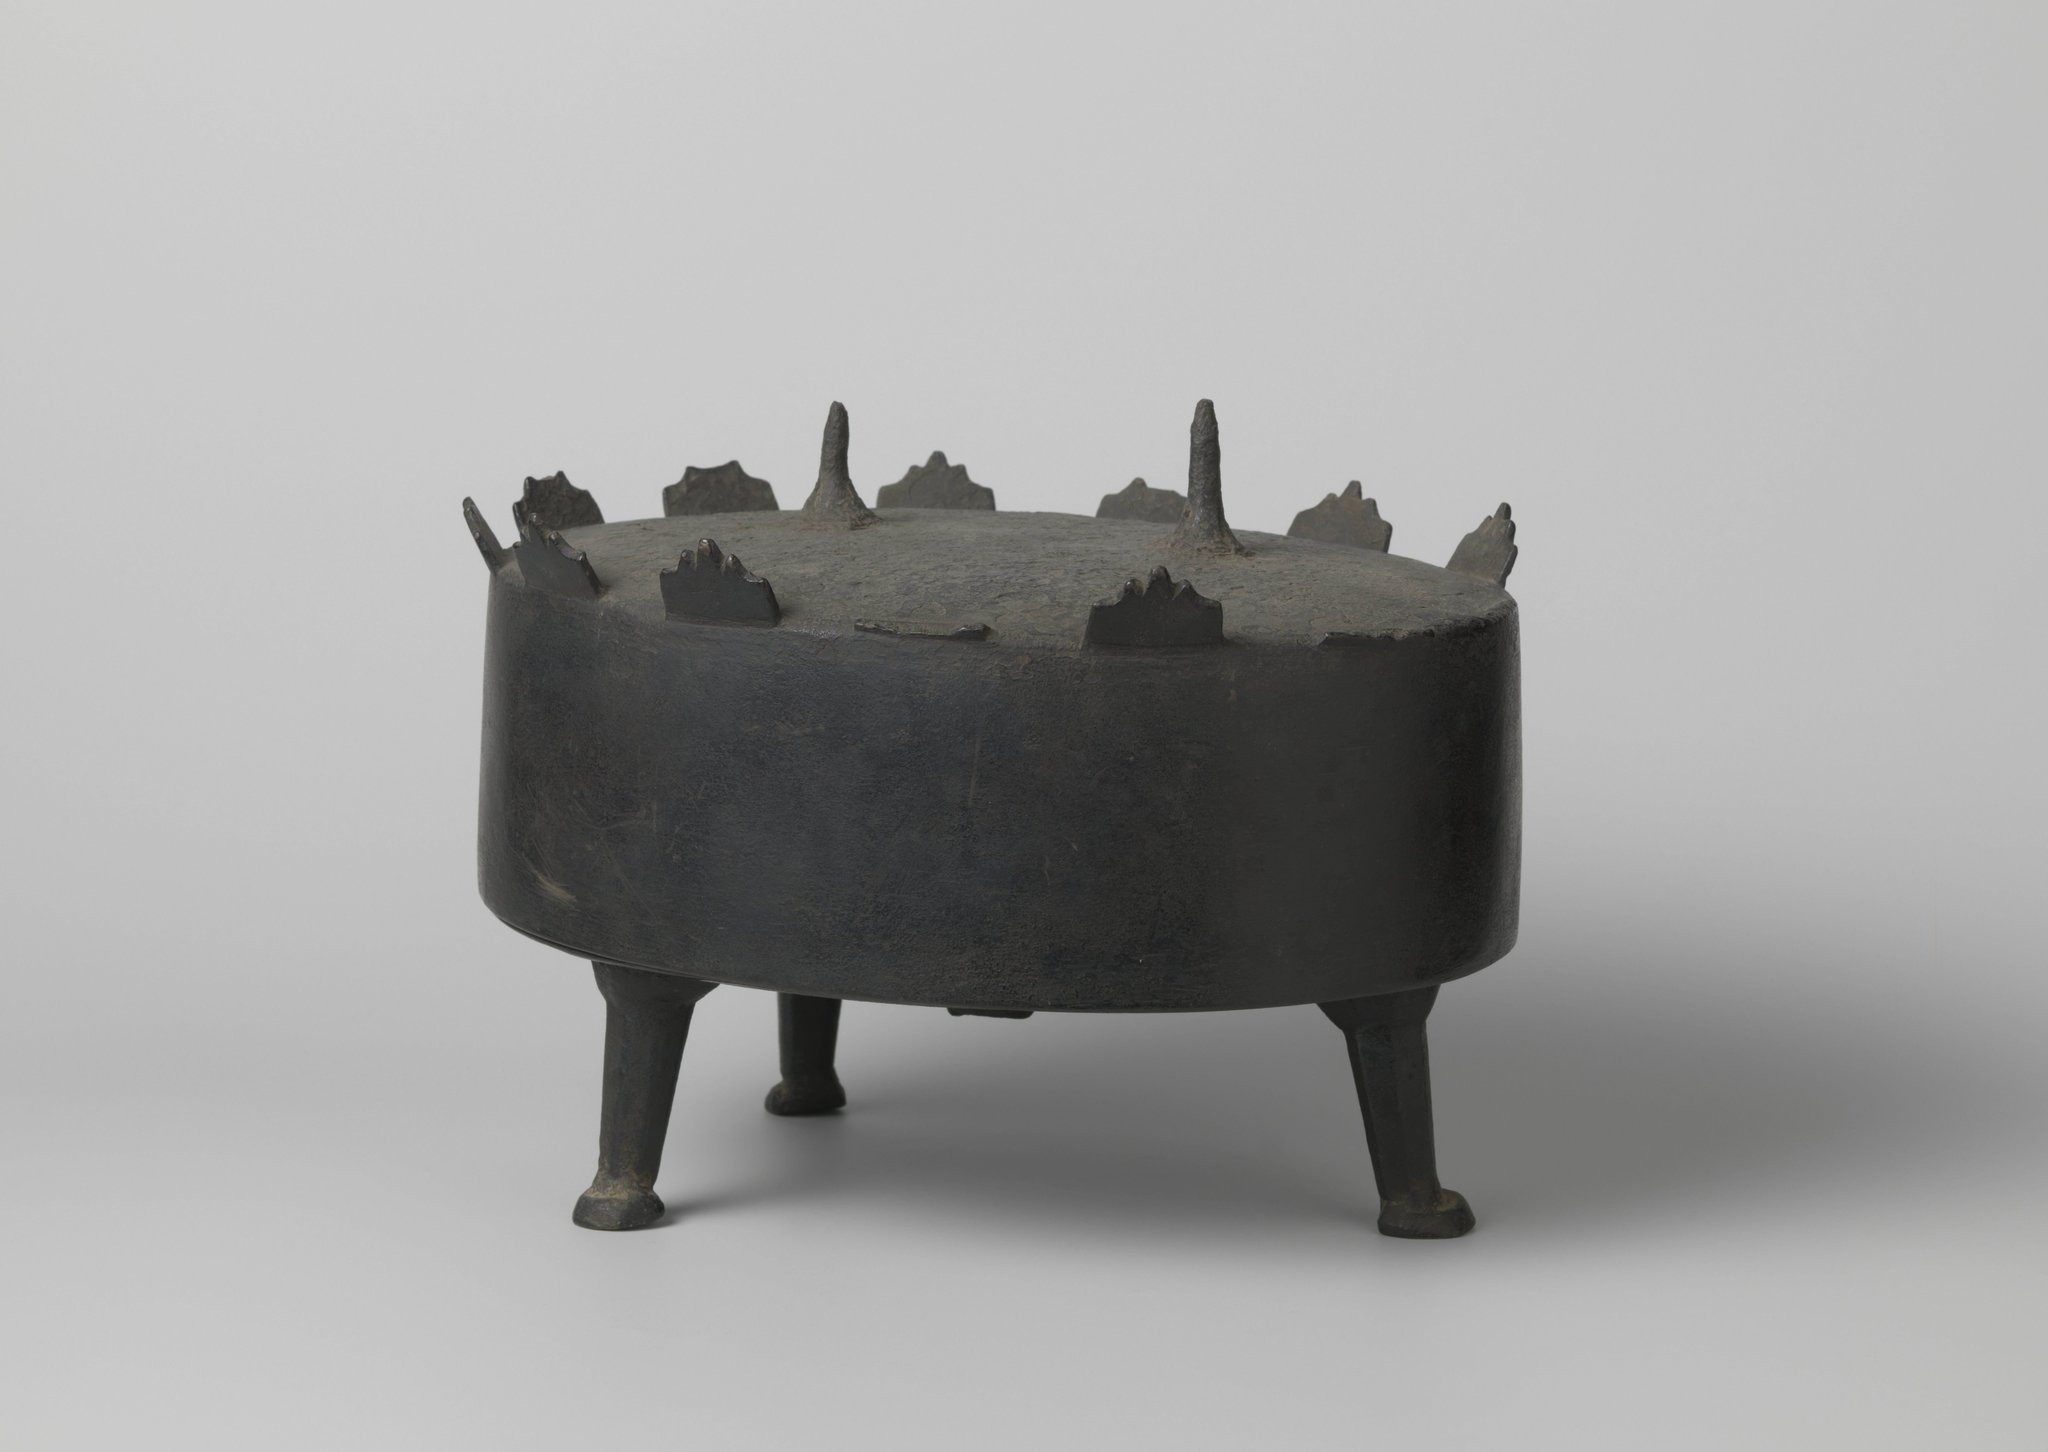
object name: pot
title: Pasteipot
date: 1500-1599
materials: bronze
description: Een bronzen ovale pot om pastei te bakken, staande op 4 poten. Het deksel, op gelijke hoogte als de pot, vertoont van boven de gedaante van de pasteikorst.